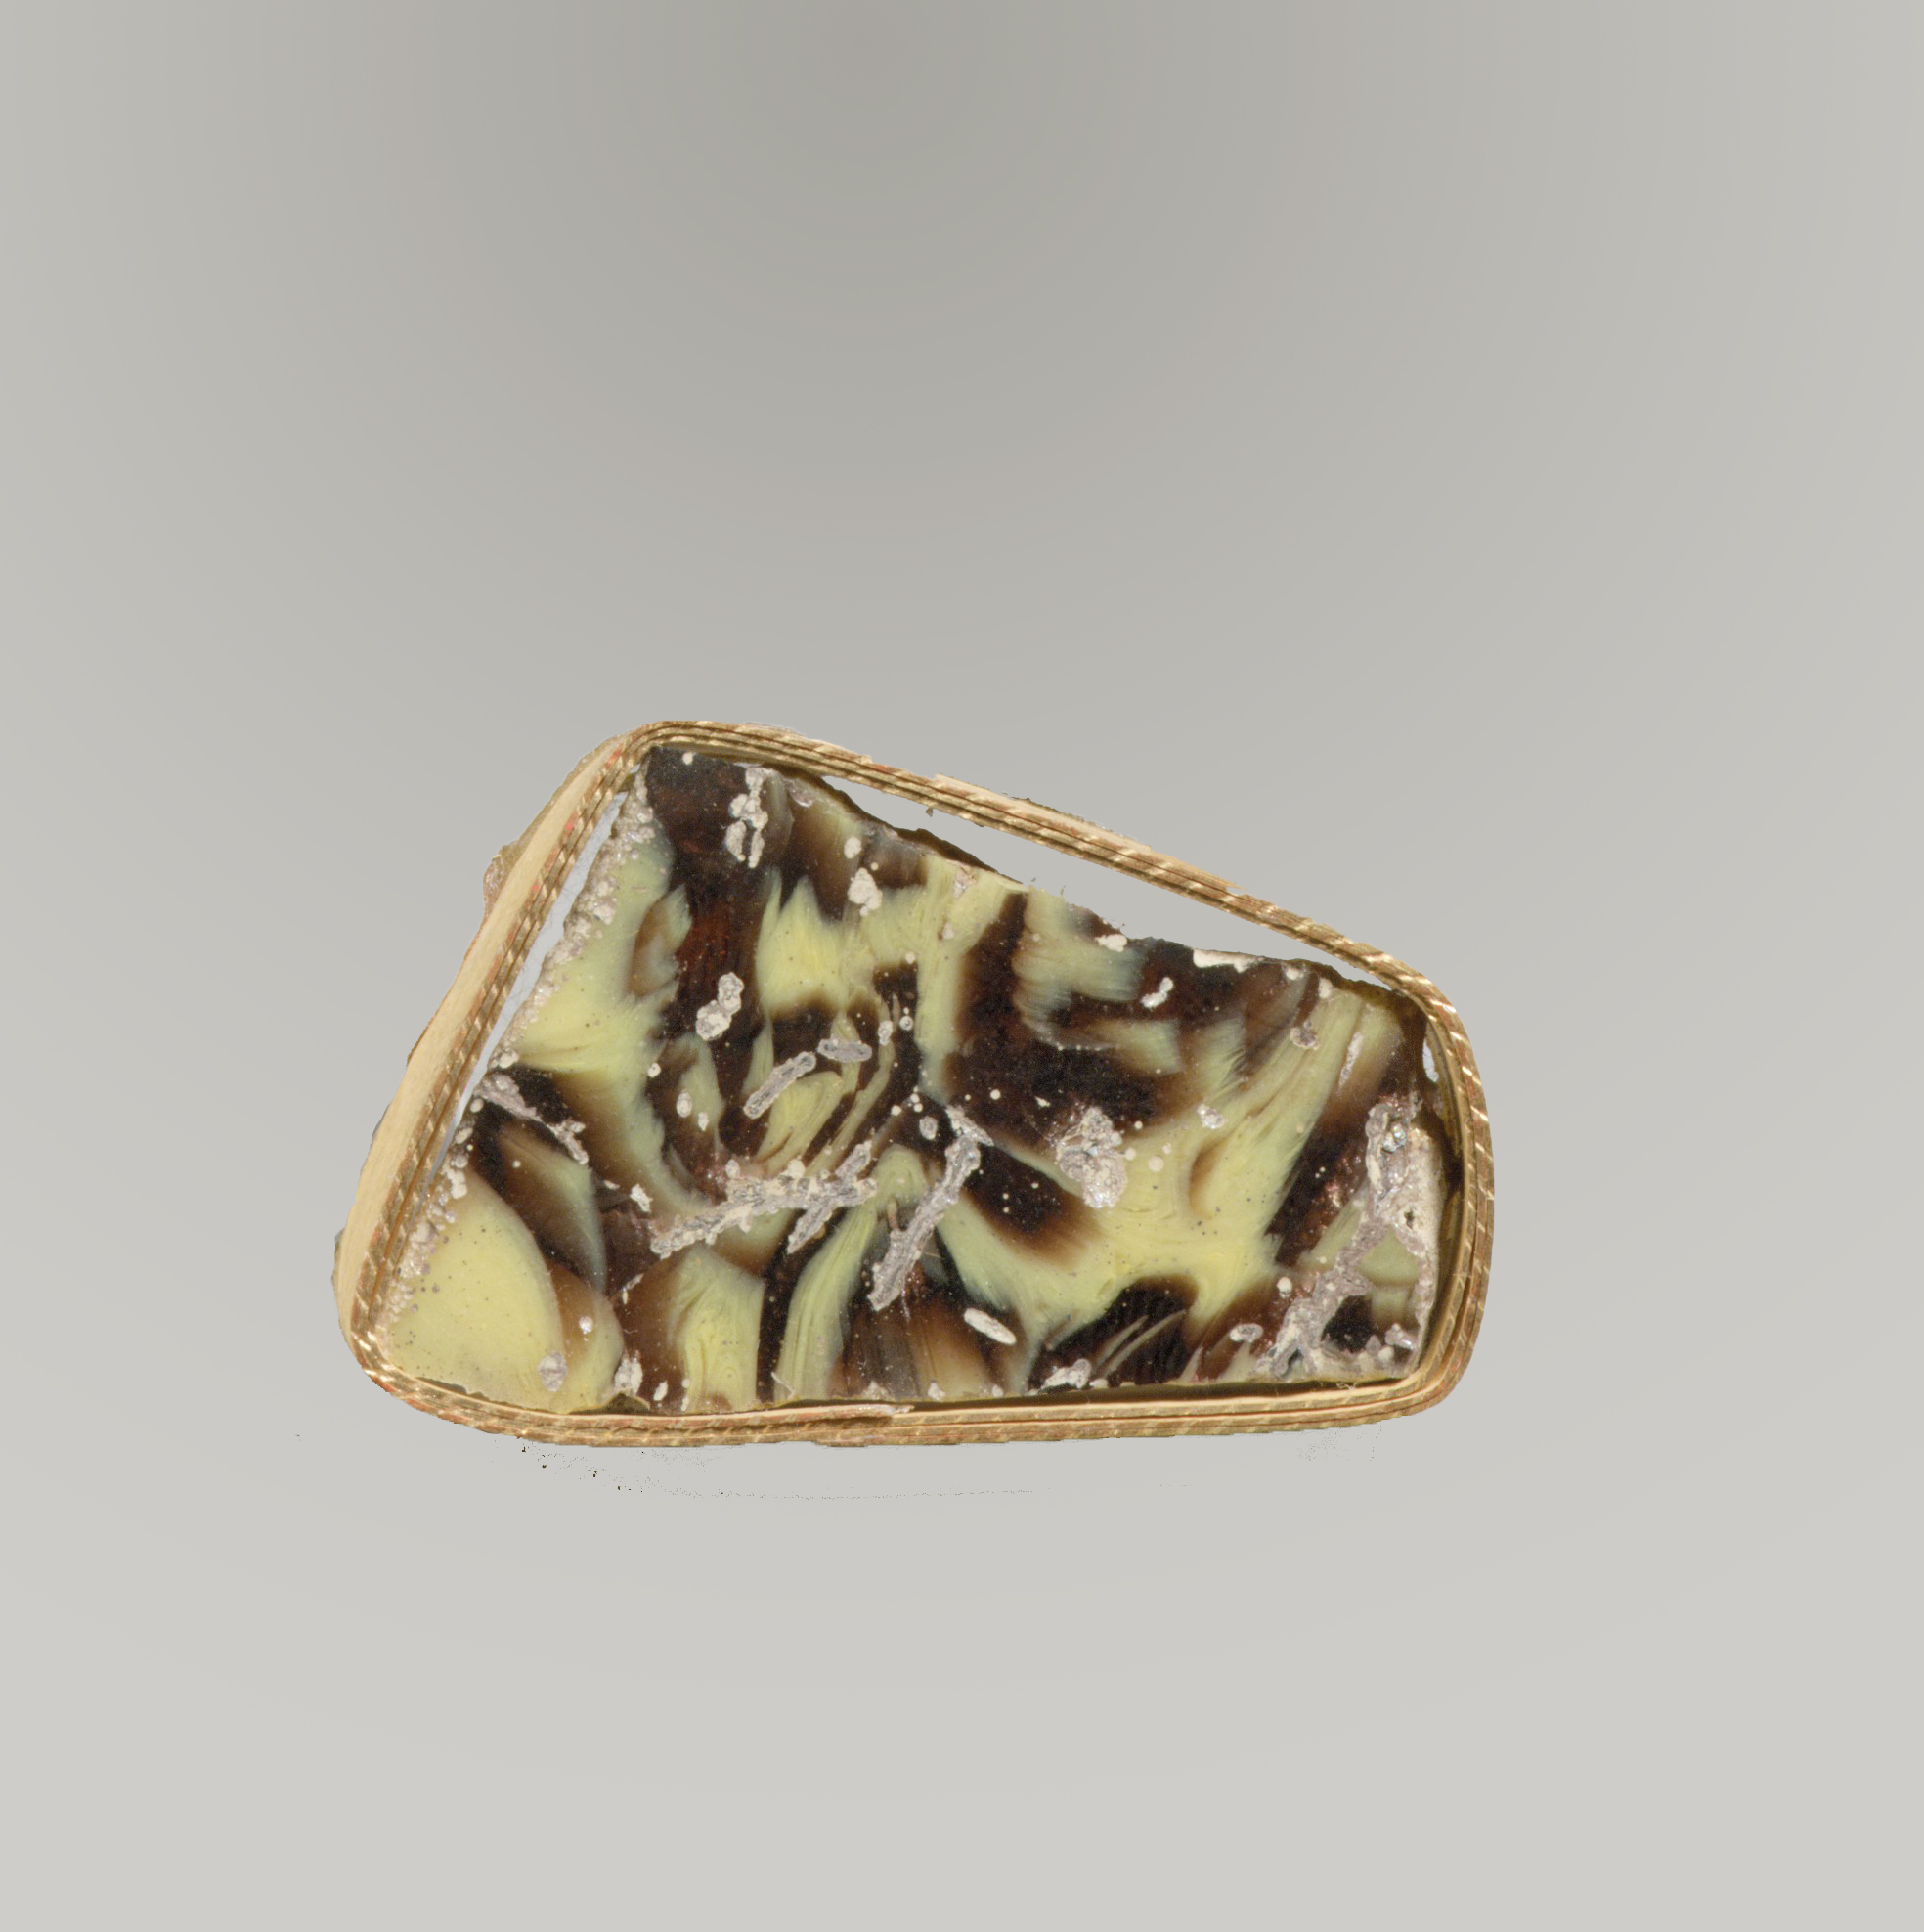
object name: fragment, mosaic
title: Glass mosaic inlay fragment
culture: roman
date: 34 BCE-33 CE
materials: glass